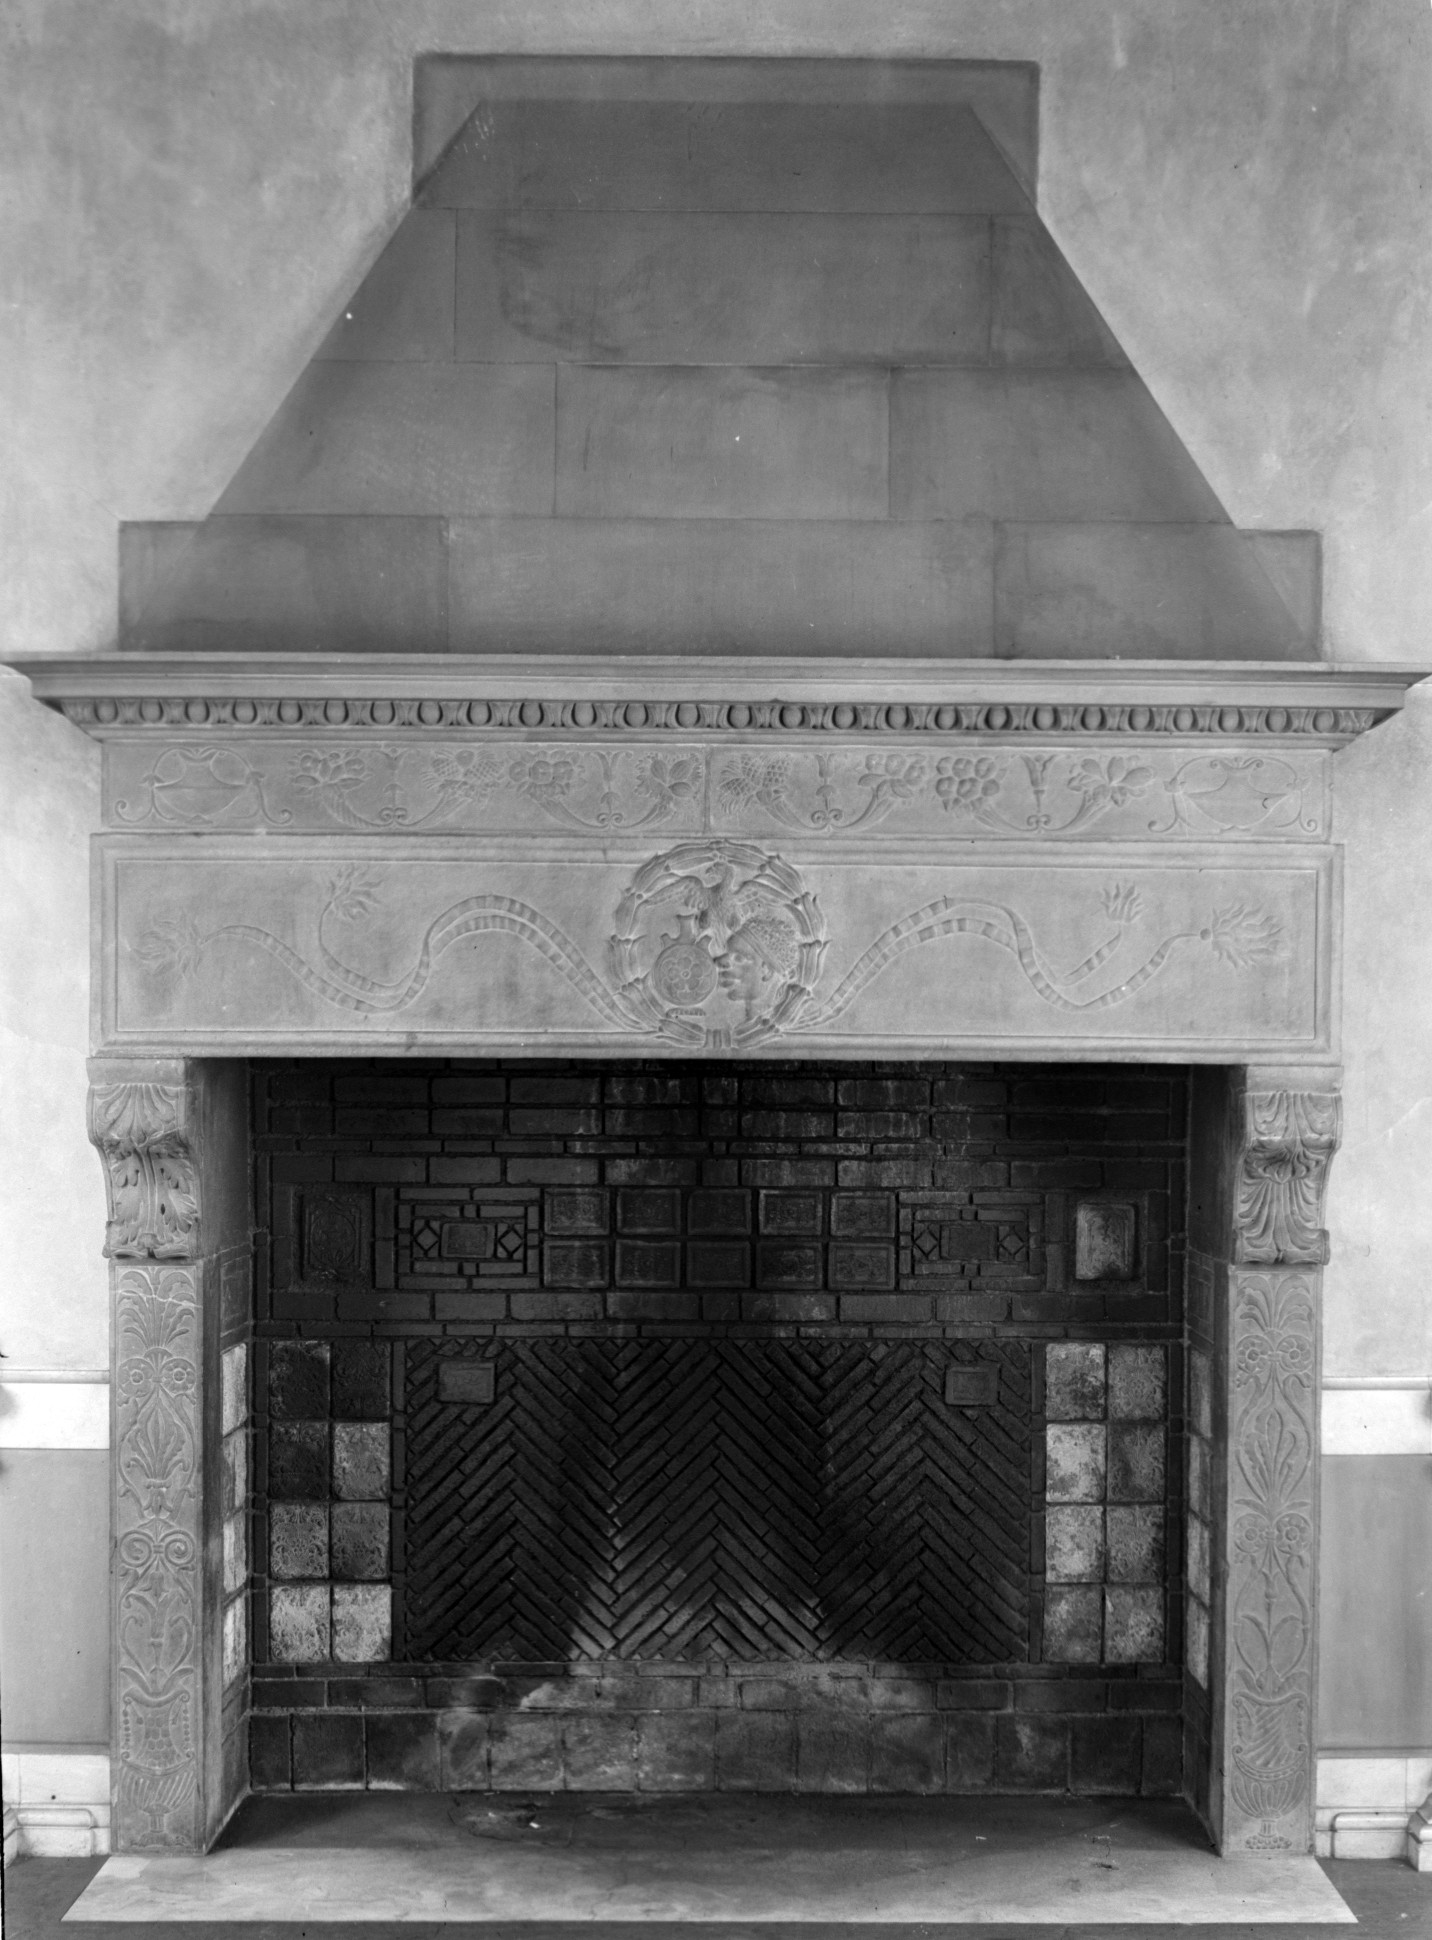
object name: mantel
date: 1476-1500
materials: limestone